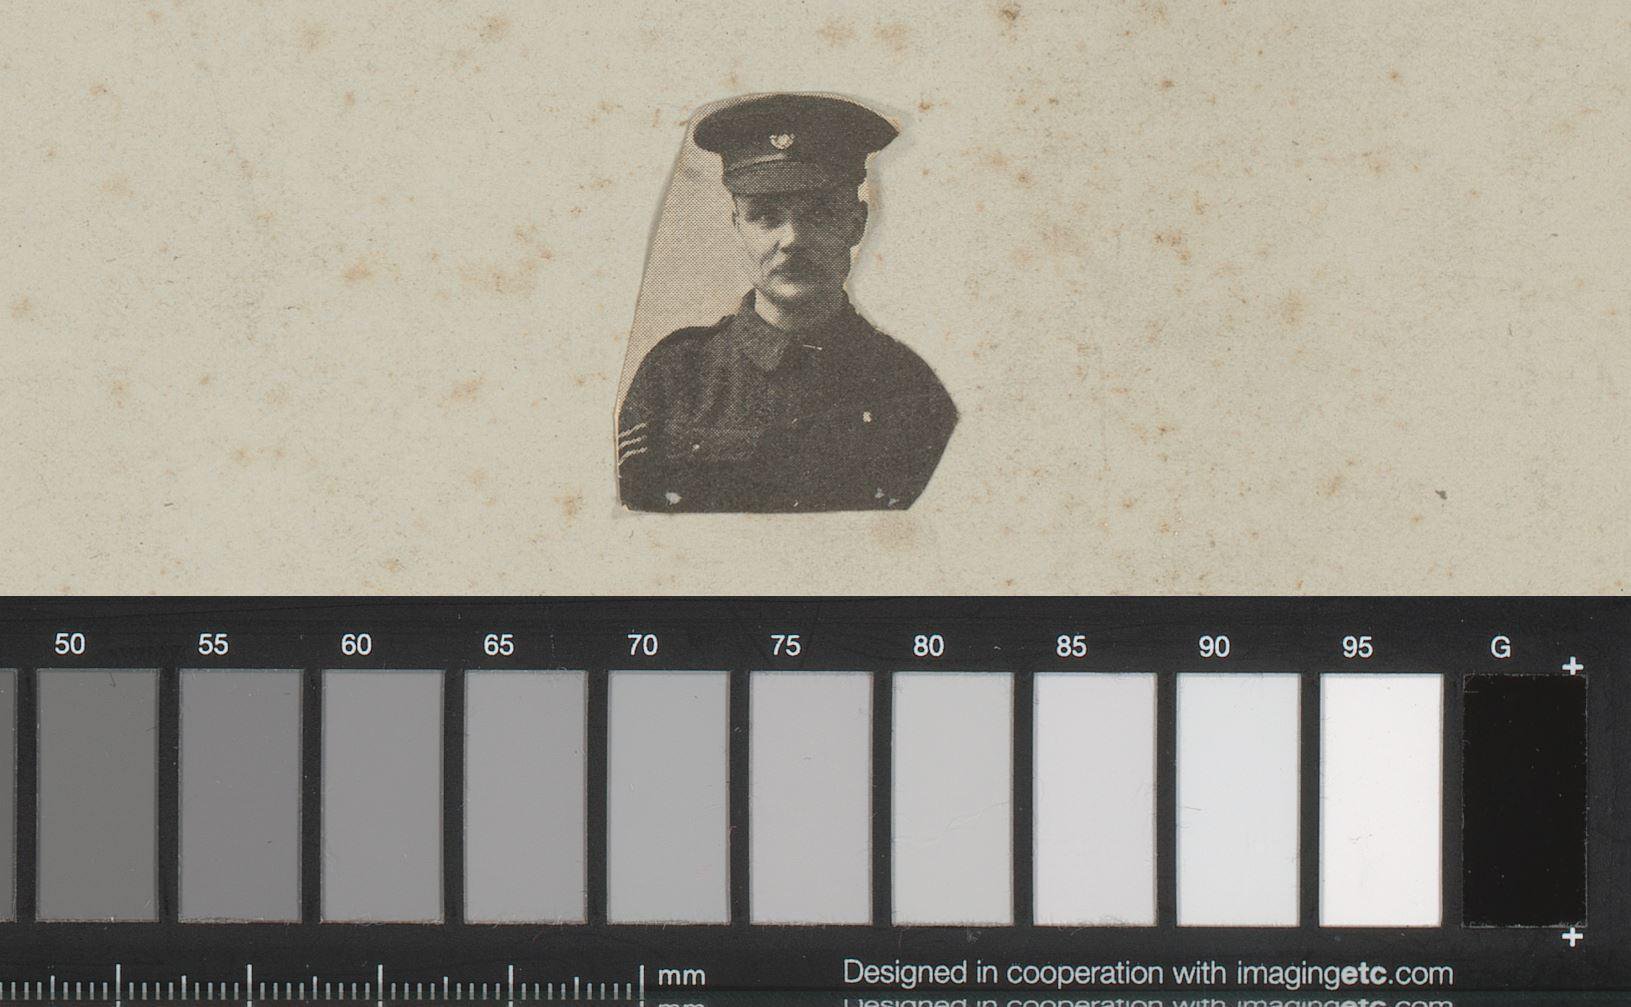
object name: photomechanical print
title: Portret van een militair in uniform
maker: Anonymous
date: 1899-1940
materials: paper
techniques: autotype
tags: adult man, historical persons, (military) uniforms